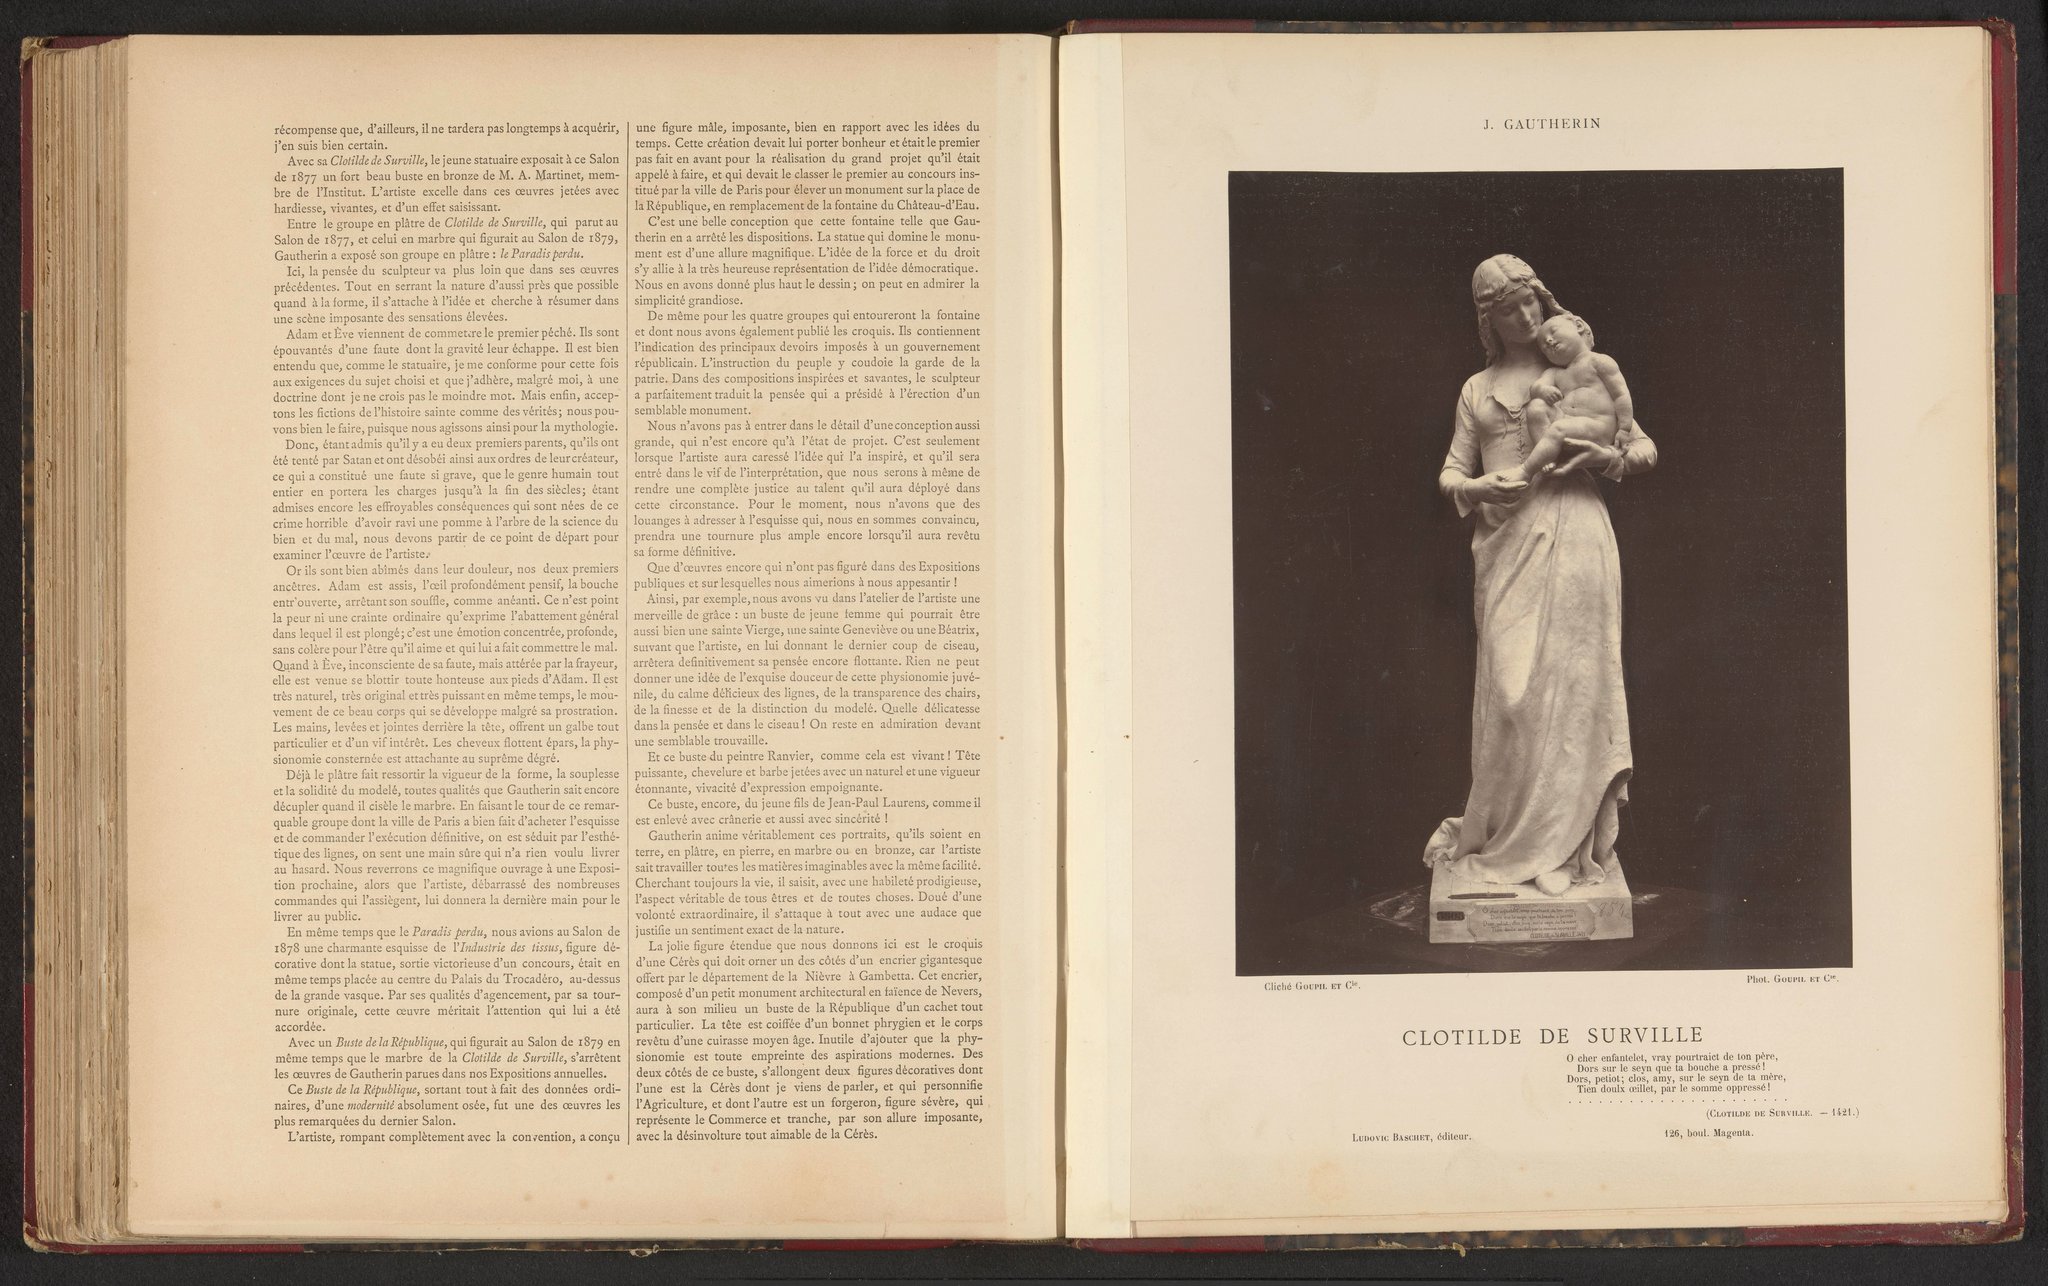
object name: page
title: Clotilde de Surville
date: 1876-1879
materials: paper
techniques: woodburytype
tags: piece of sculpture, reproduction of a piece of sculpture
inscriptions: inscription: ‘126, boul. Magenta.’, inscription: ‘O cher engantelet, vray pourtraict de ton père (...)’